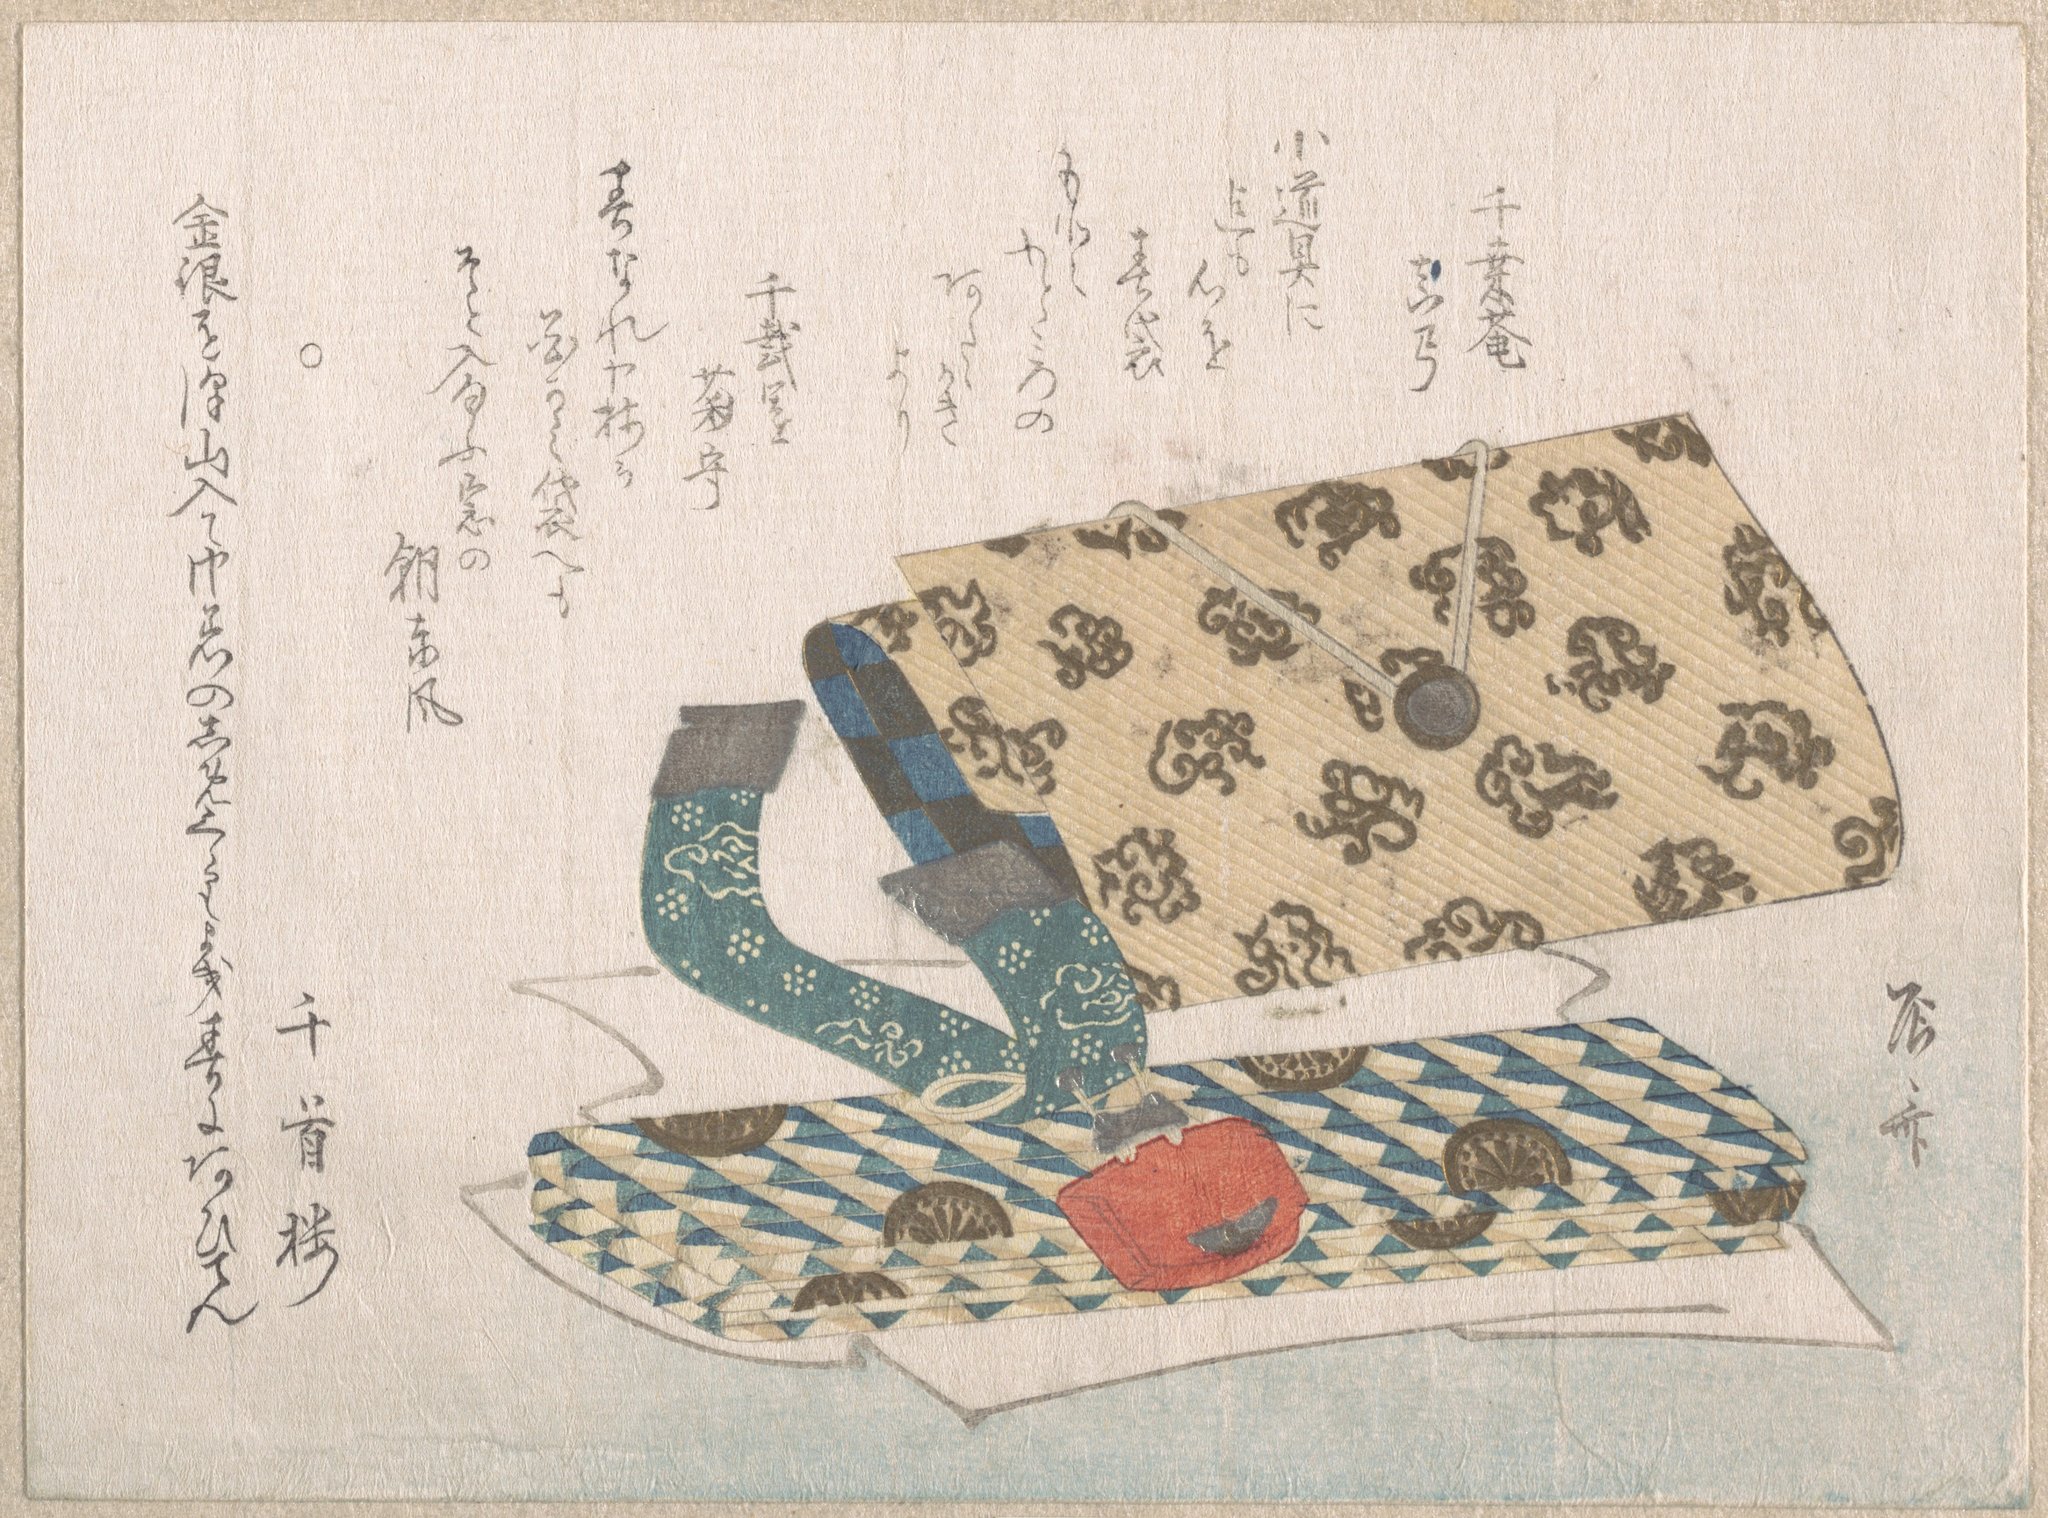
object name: woodblock print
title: Pocketbook with Its Fittings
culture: japanese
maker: ryūryūkyo shinsai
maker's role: artist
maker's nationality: japanese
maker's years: 1799-1823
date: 1801-1900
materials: ink, paper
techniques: surimono, woodblock print